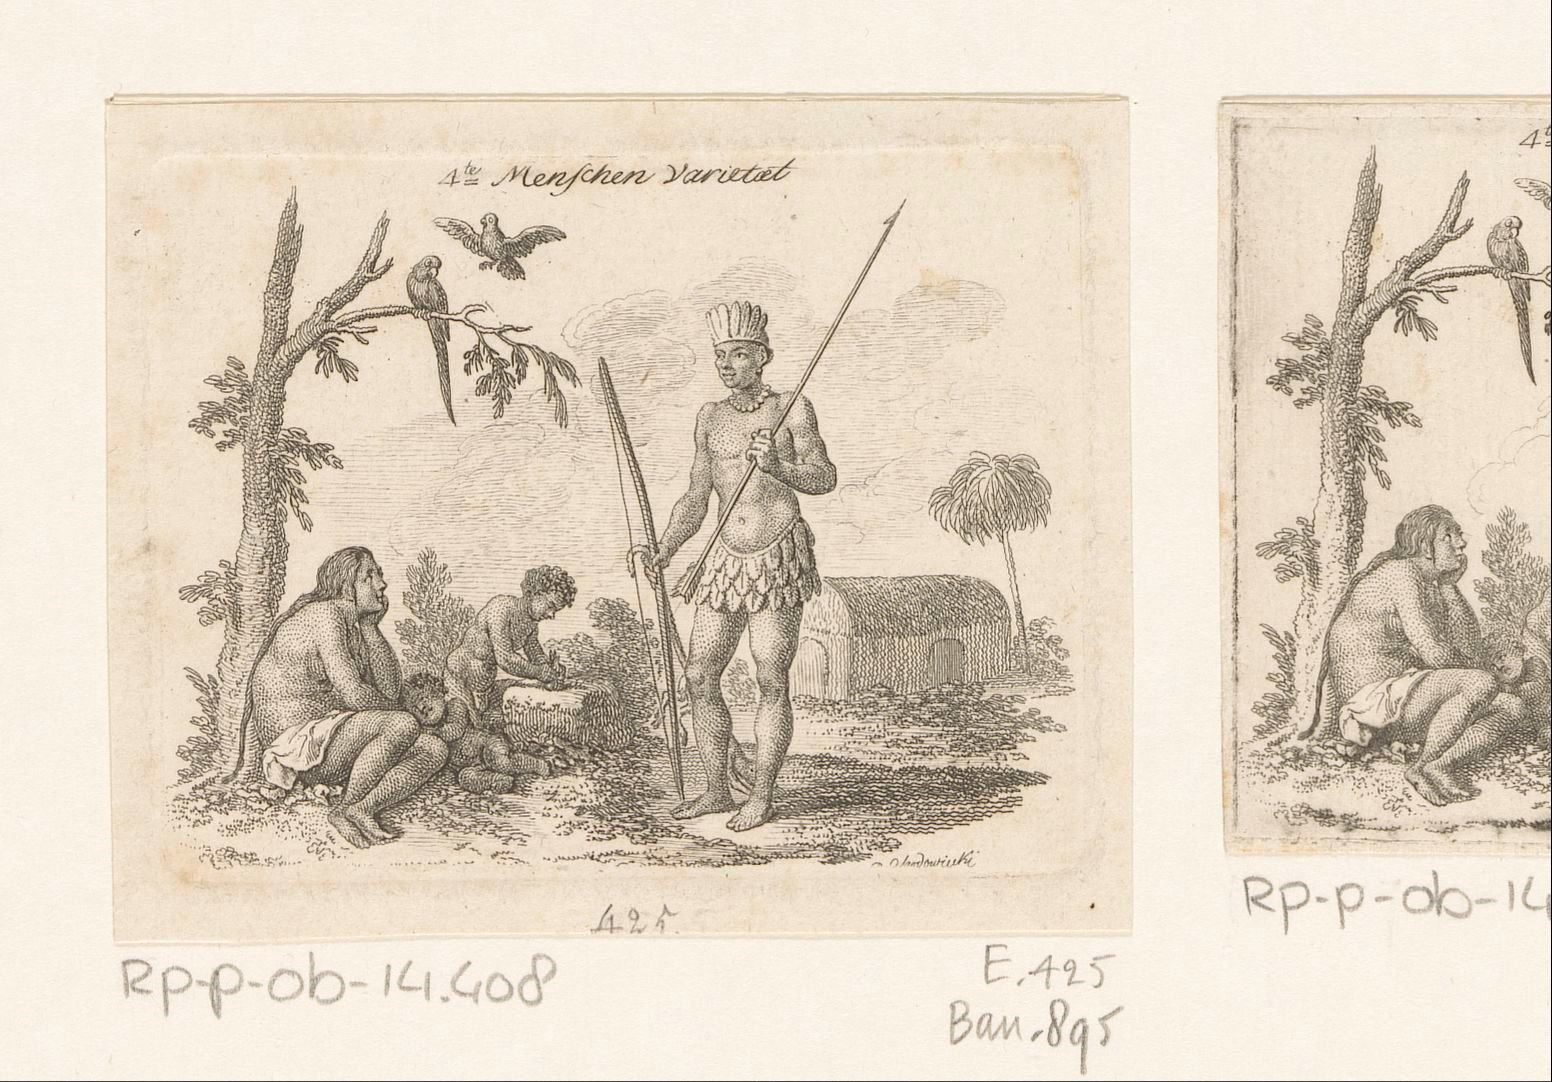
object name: print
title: Oorspronkelijke bewoners van Amerika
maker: daniel nikolaus chodowiecki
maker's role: draughtsman, print maker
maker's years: 1726-1801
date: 1782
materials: paper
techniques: etching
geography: berlin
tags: physicist, archer's weapons: bow and arrow, ornamental birds: parrot, native peoples of the americas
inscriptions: collector's mark: Lugt 2228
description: Prent gebruikt voor: Blumenbach, Johann Friedrich. Beyträge zur Naturgeschichte von Joh. Fr. Blumenbach. Göttingen: Heinrich Bieterich, 1790.